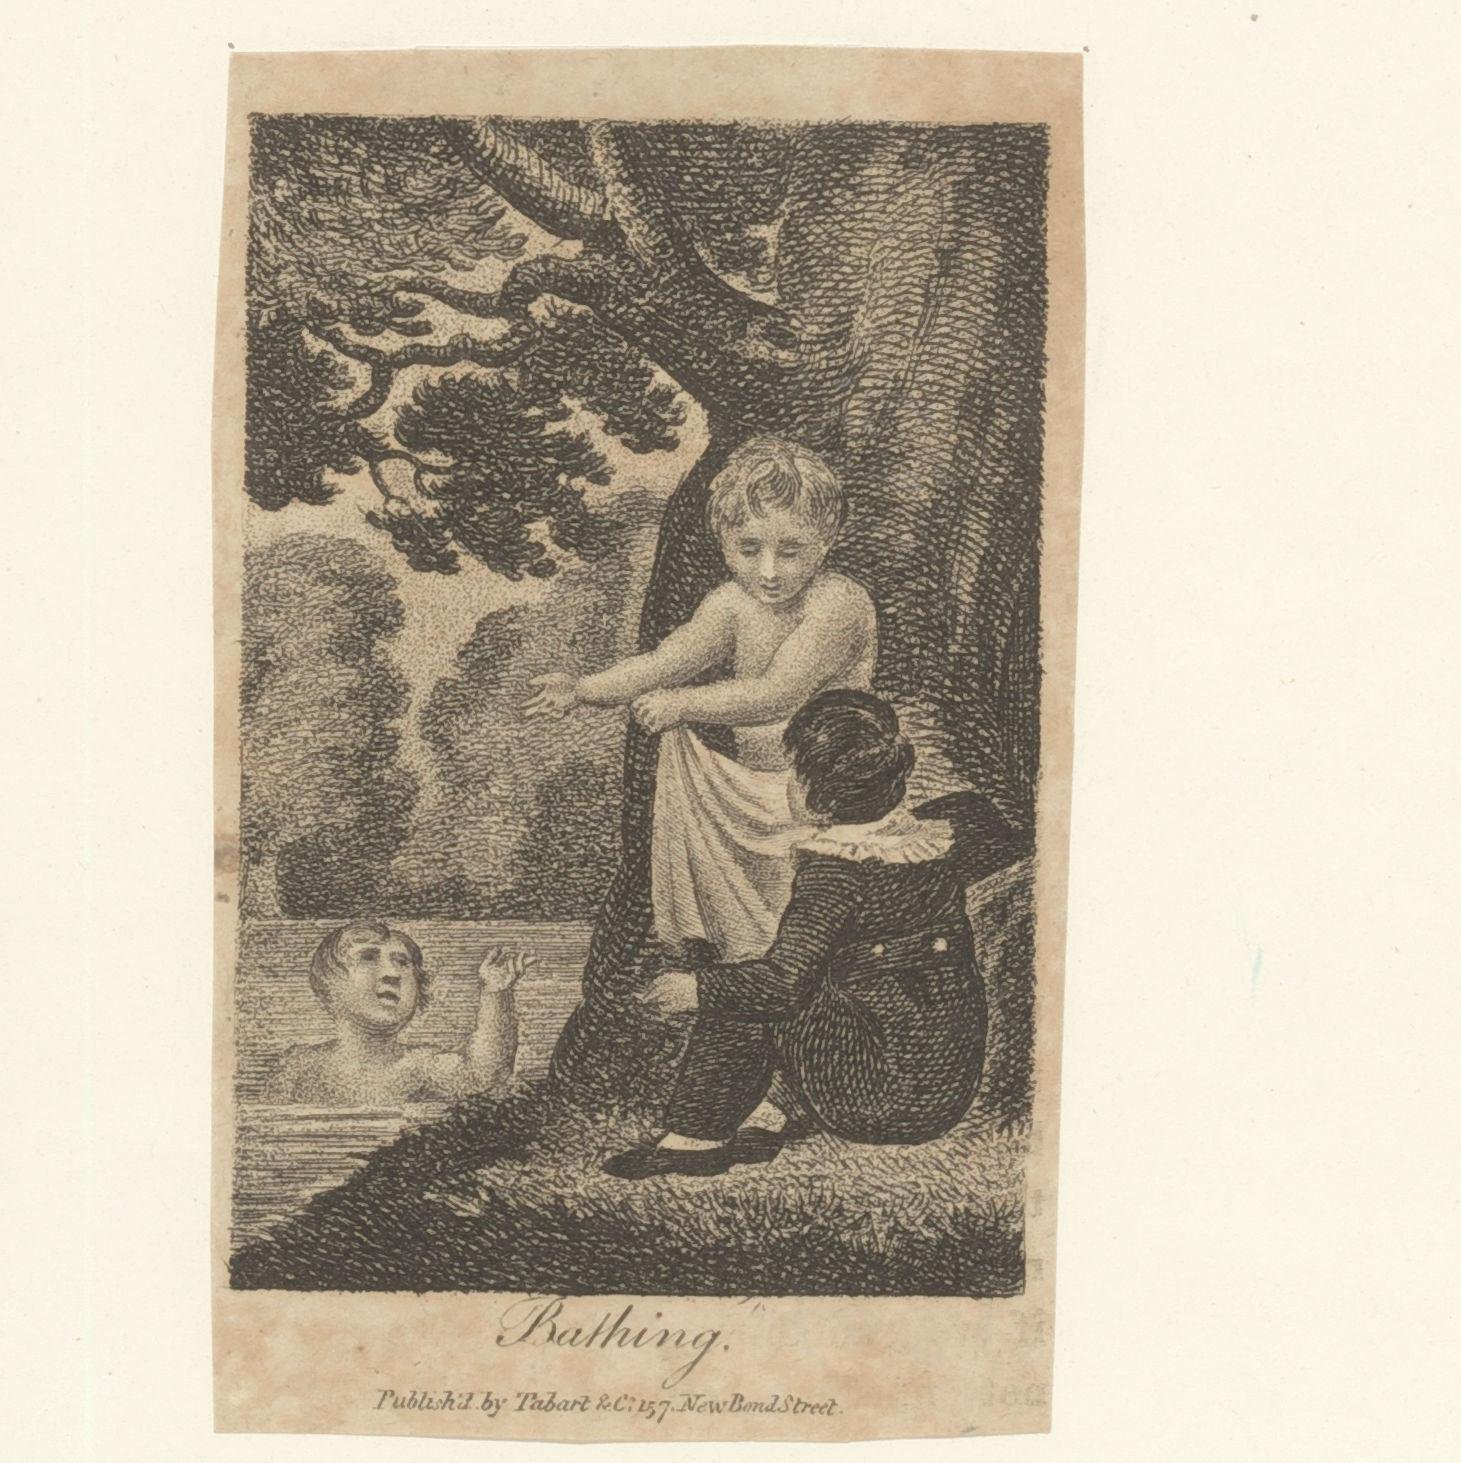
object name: print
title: Bathing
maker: Anonymous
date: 1812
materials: paper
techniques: engraving, etching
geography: london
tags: taking a bath, child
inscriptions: stamp, collector's mark: Lugt 1641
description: Onderwerpsrubrieken binnen de Atlas Zeden en Gewoonten: Zeden en Gewoonten in Engeren Zin, Des menschen beging, midden en einde, Kinderleven – Kinderspel en Kinderprenten.